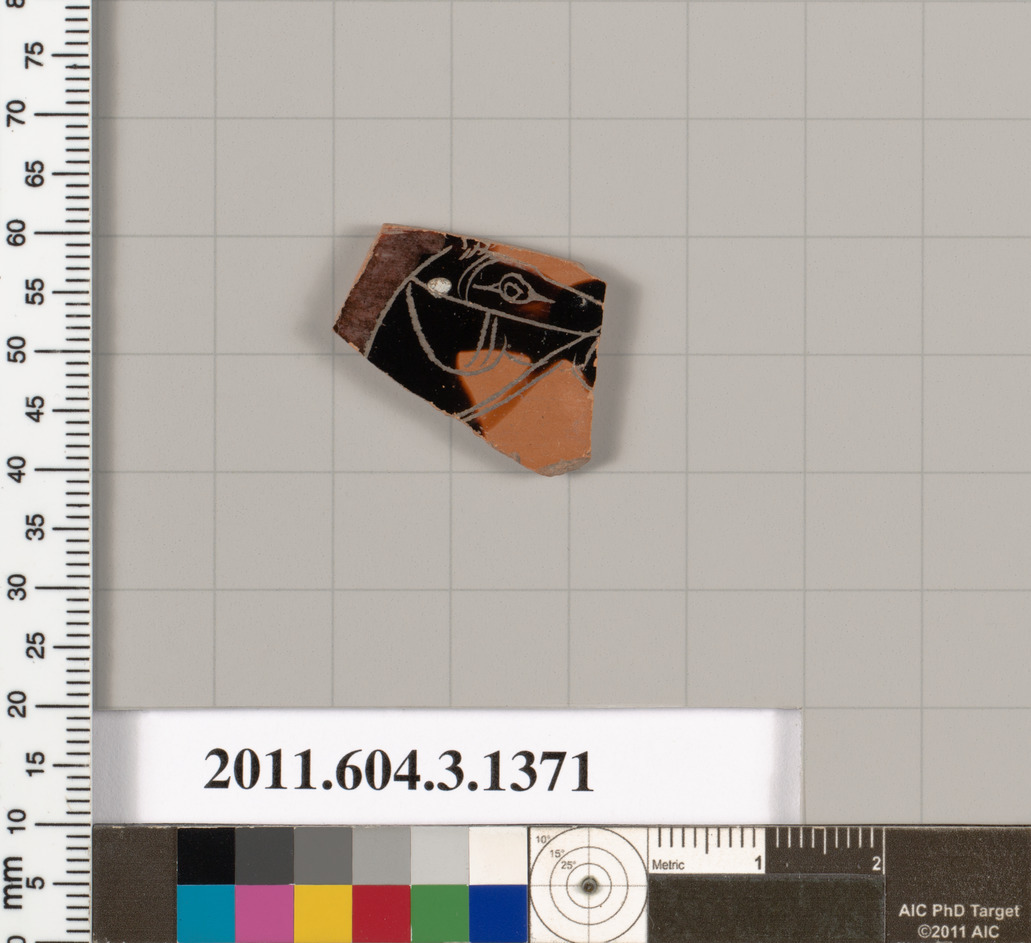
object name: skyphos fragment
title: Terracotta fragment of a skyphos (deep drinking cup)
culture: greek, attic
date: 534-468 BCE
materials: terracotta